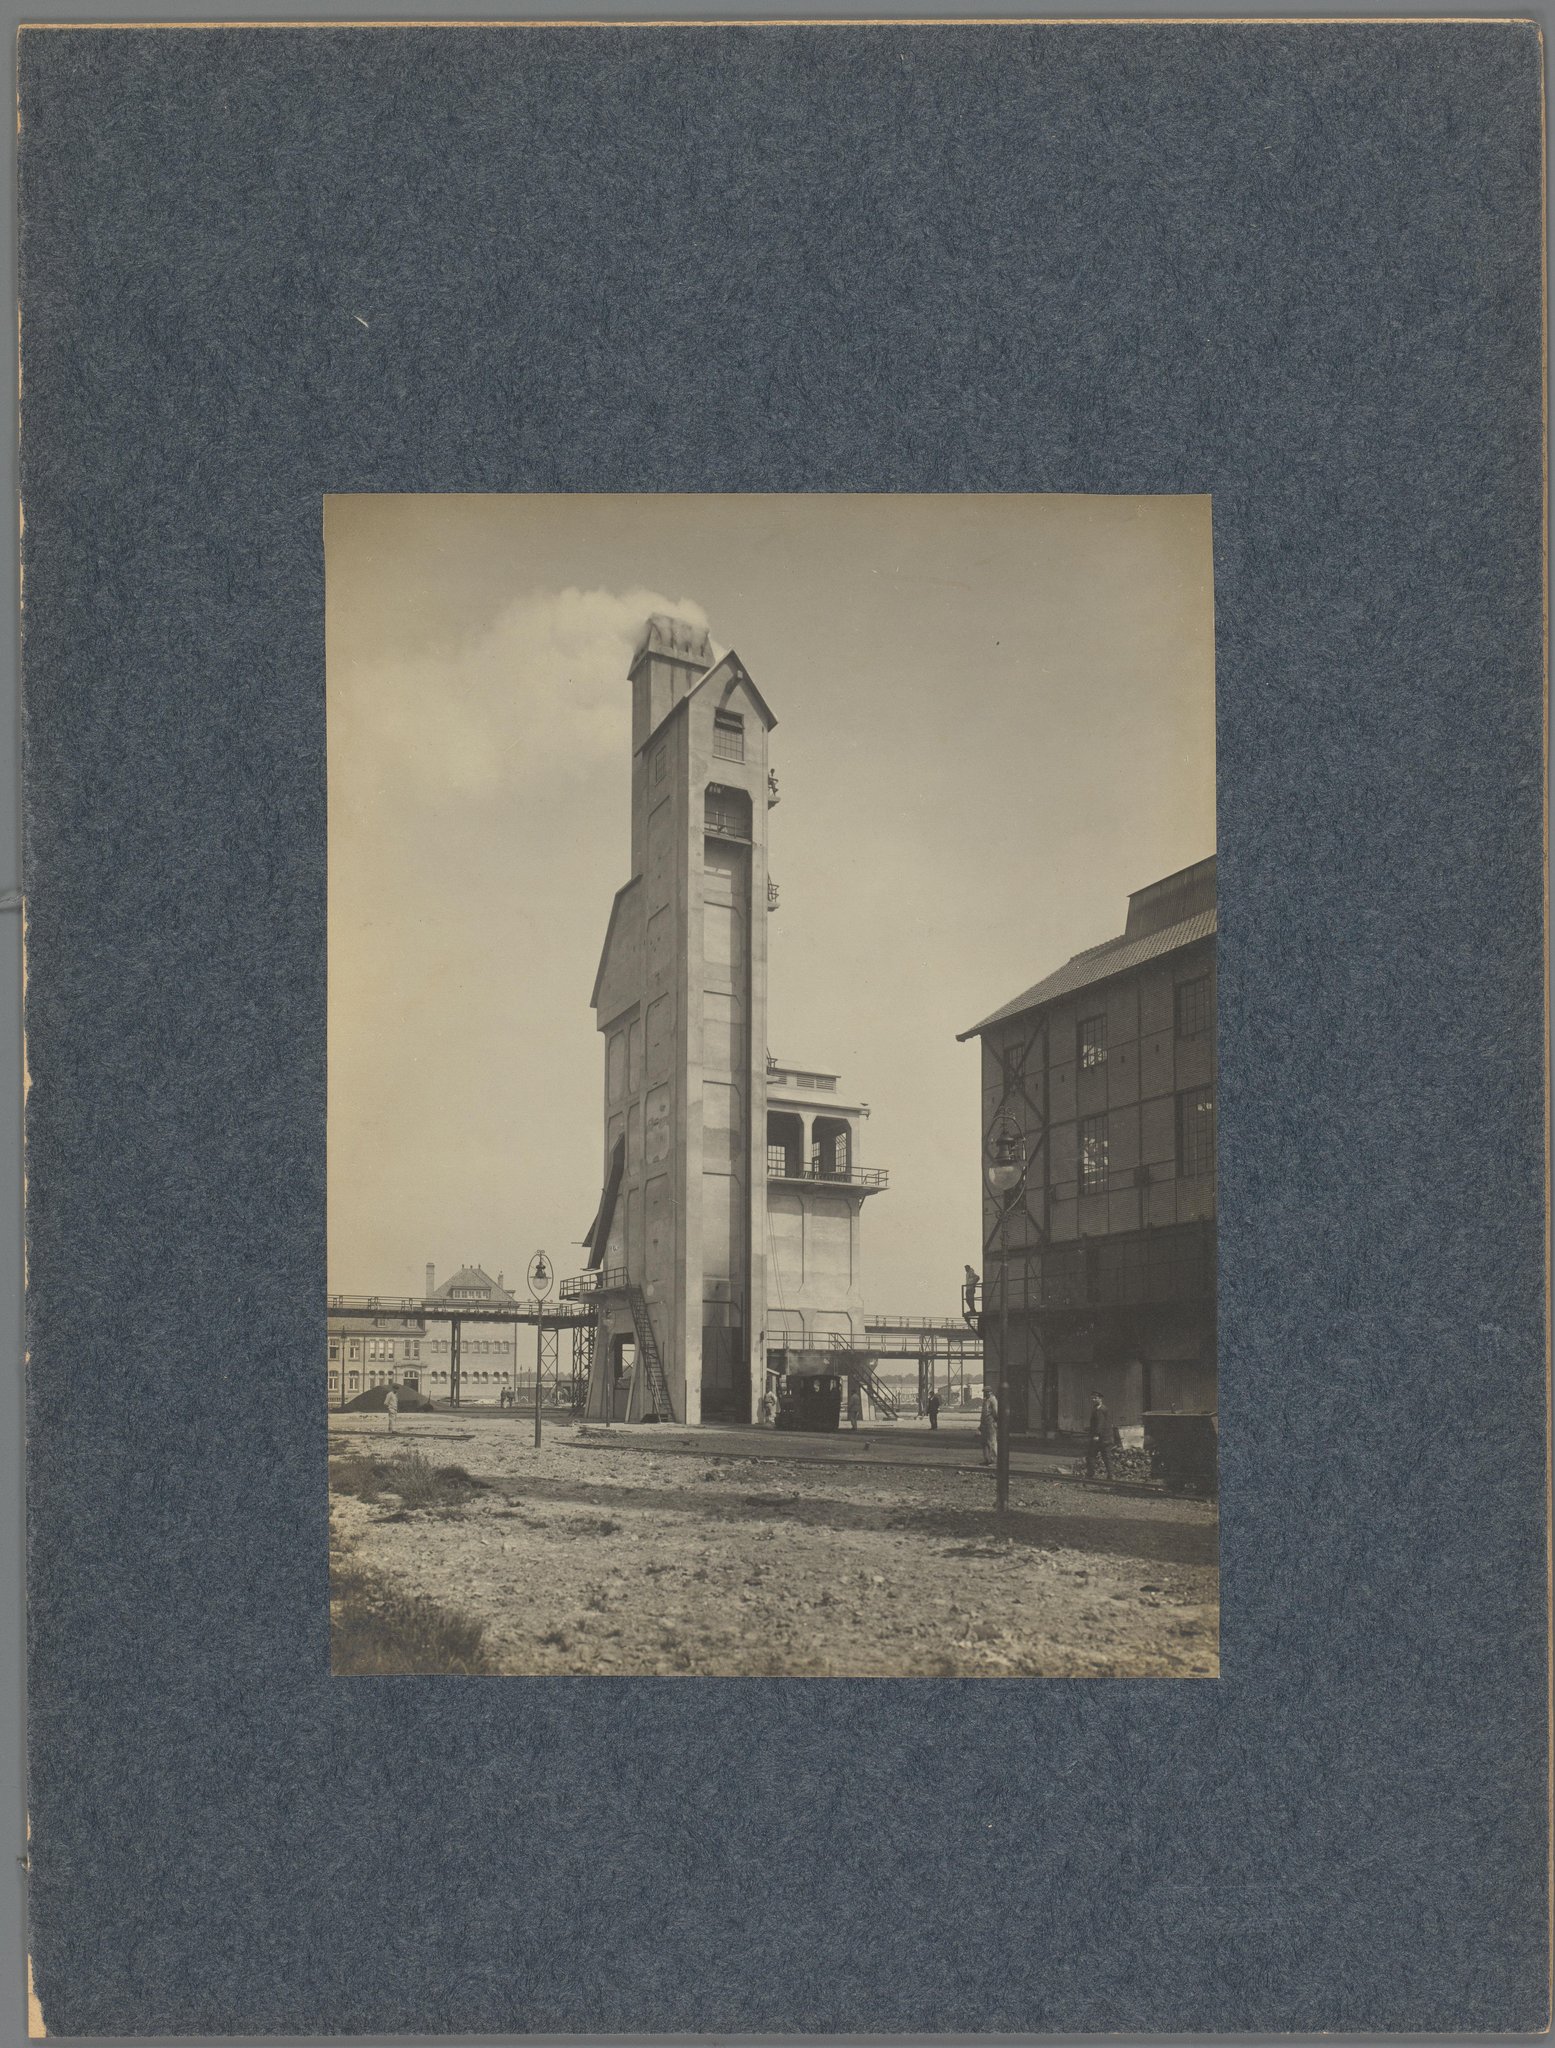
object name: photograph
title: Cokesoven van de gasfabriek in de Keilehaven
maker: willem sr. bleuzé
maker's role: fotograaf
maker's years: 1873-1948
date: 1912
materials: paper, cardboard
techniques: gelatin silver print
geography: rotterdam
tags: factory-building, gasworks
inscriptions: number: ‘3’, address: ‘W. BLEUZÉ/ ROTTERDAM/ JONKER FRANSSTRAAT 66’